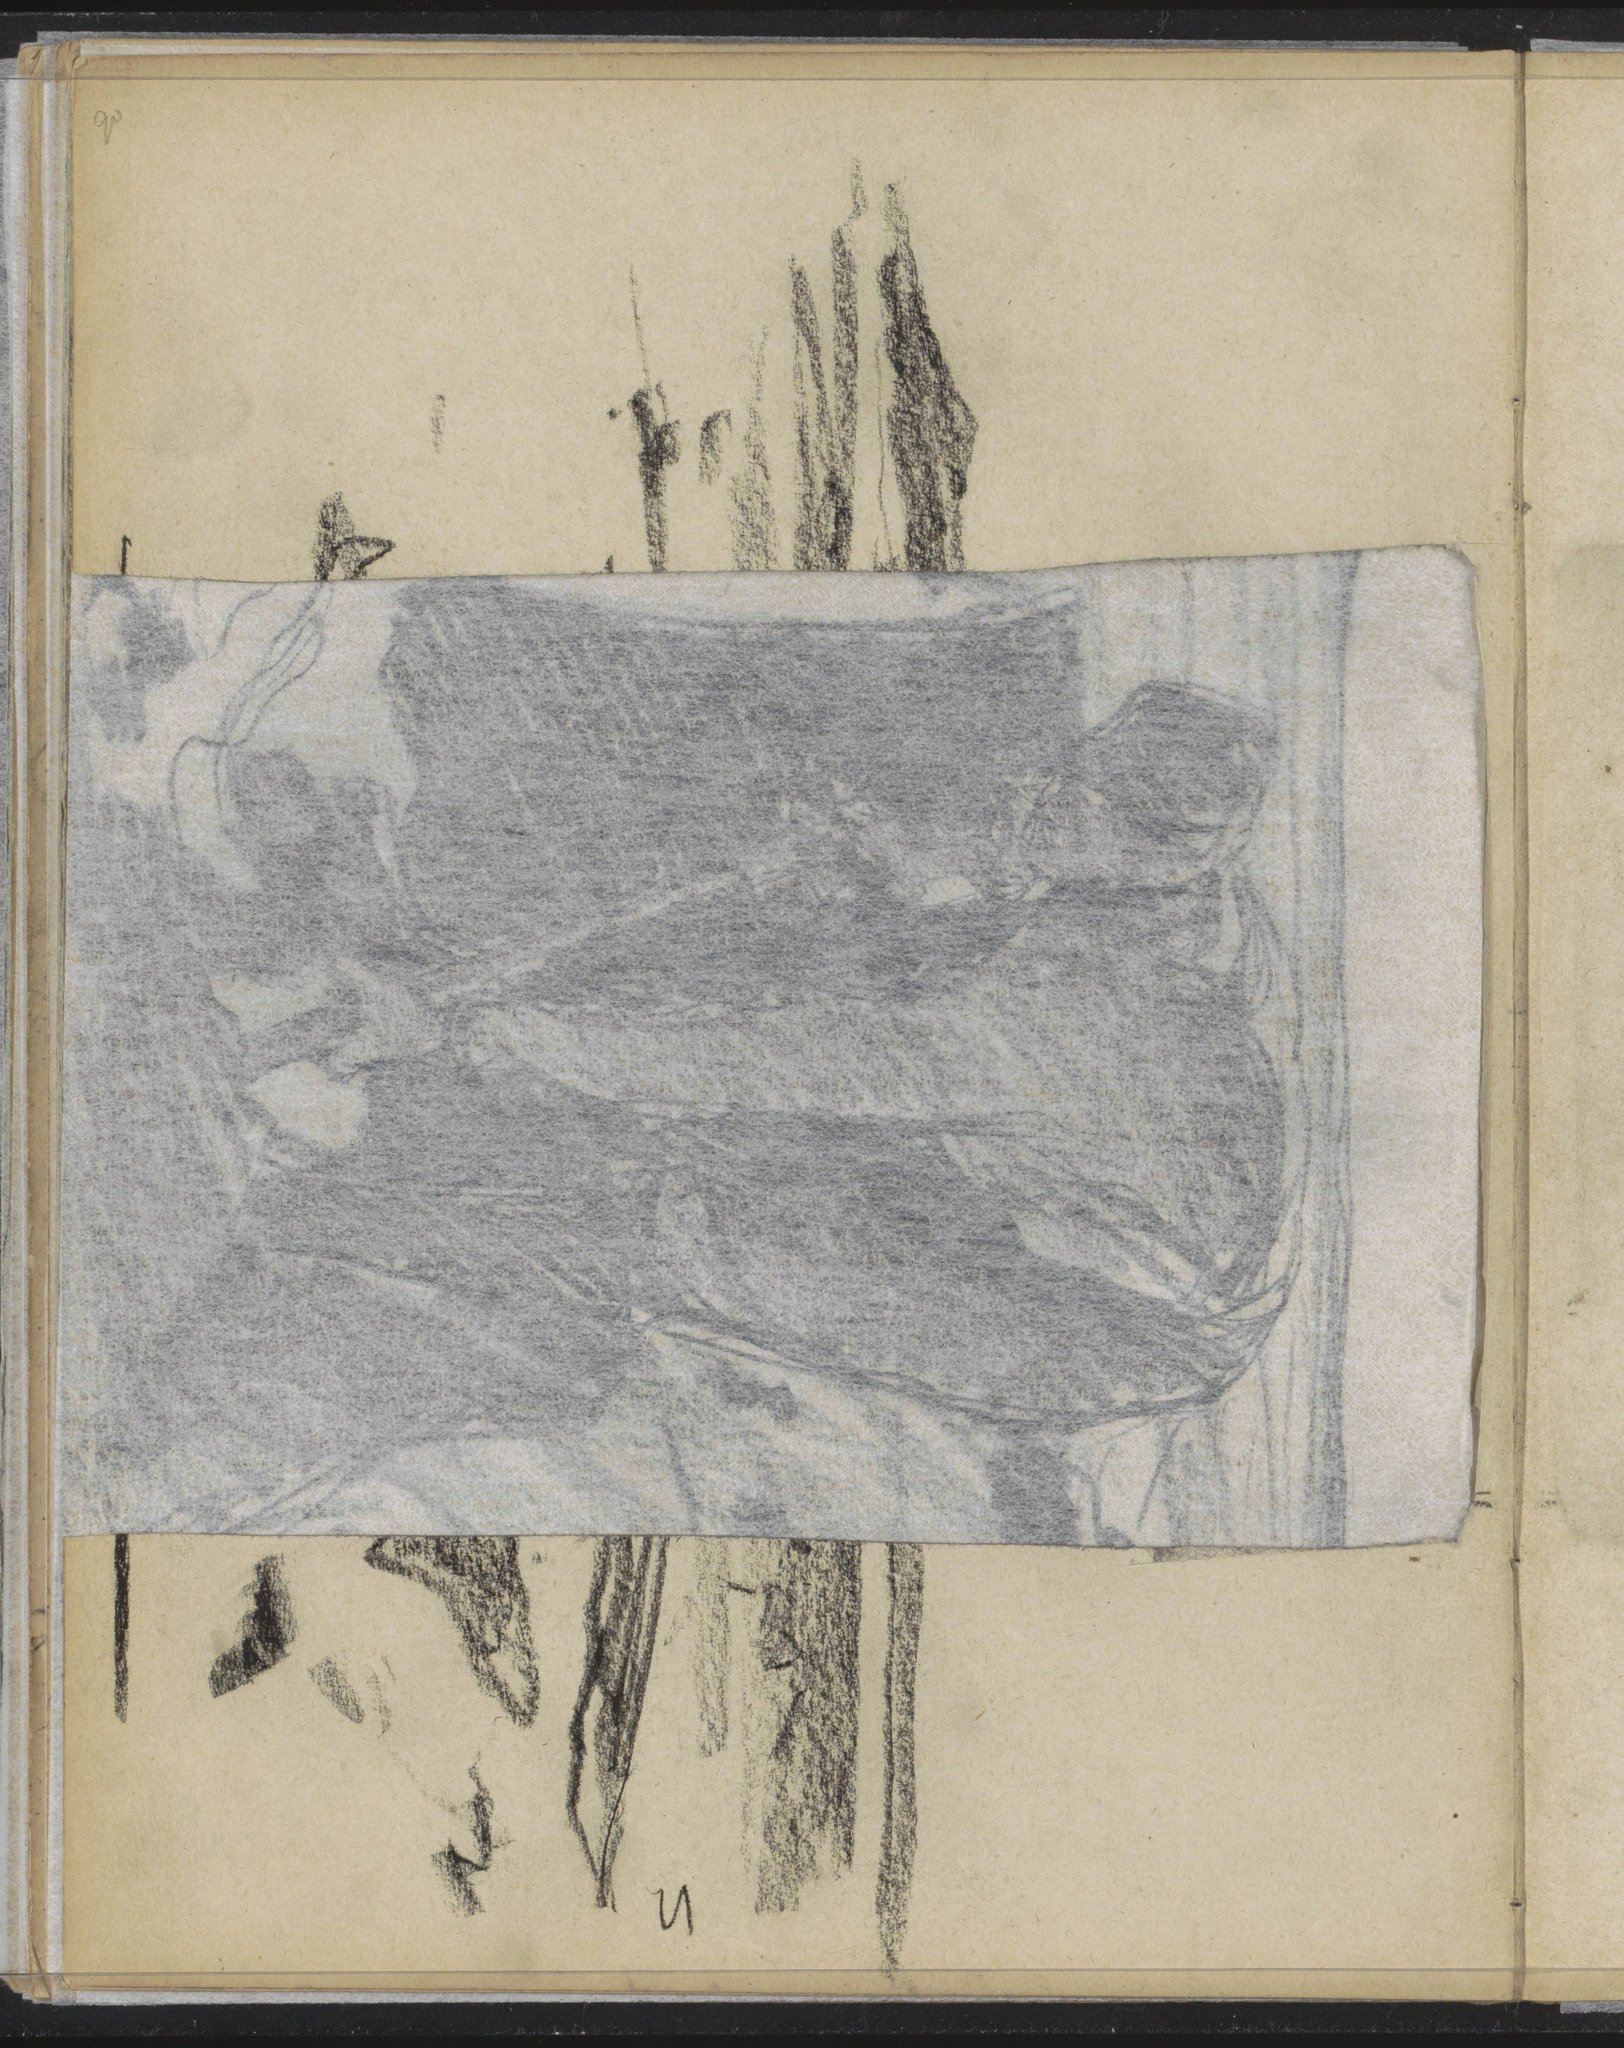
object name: sketchbook leaf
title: Landschap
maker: willem witsen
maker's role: draughtsman, painter, print maker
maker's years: 1860-1923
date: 1884-1887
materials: chalk, paper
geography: ewijkshoeve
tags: landscapes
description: Pagina 90 uit een schetsboek met 49 bladen.